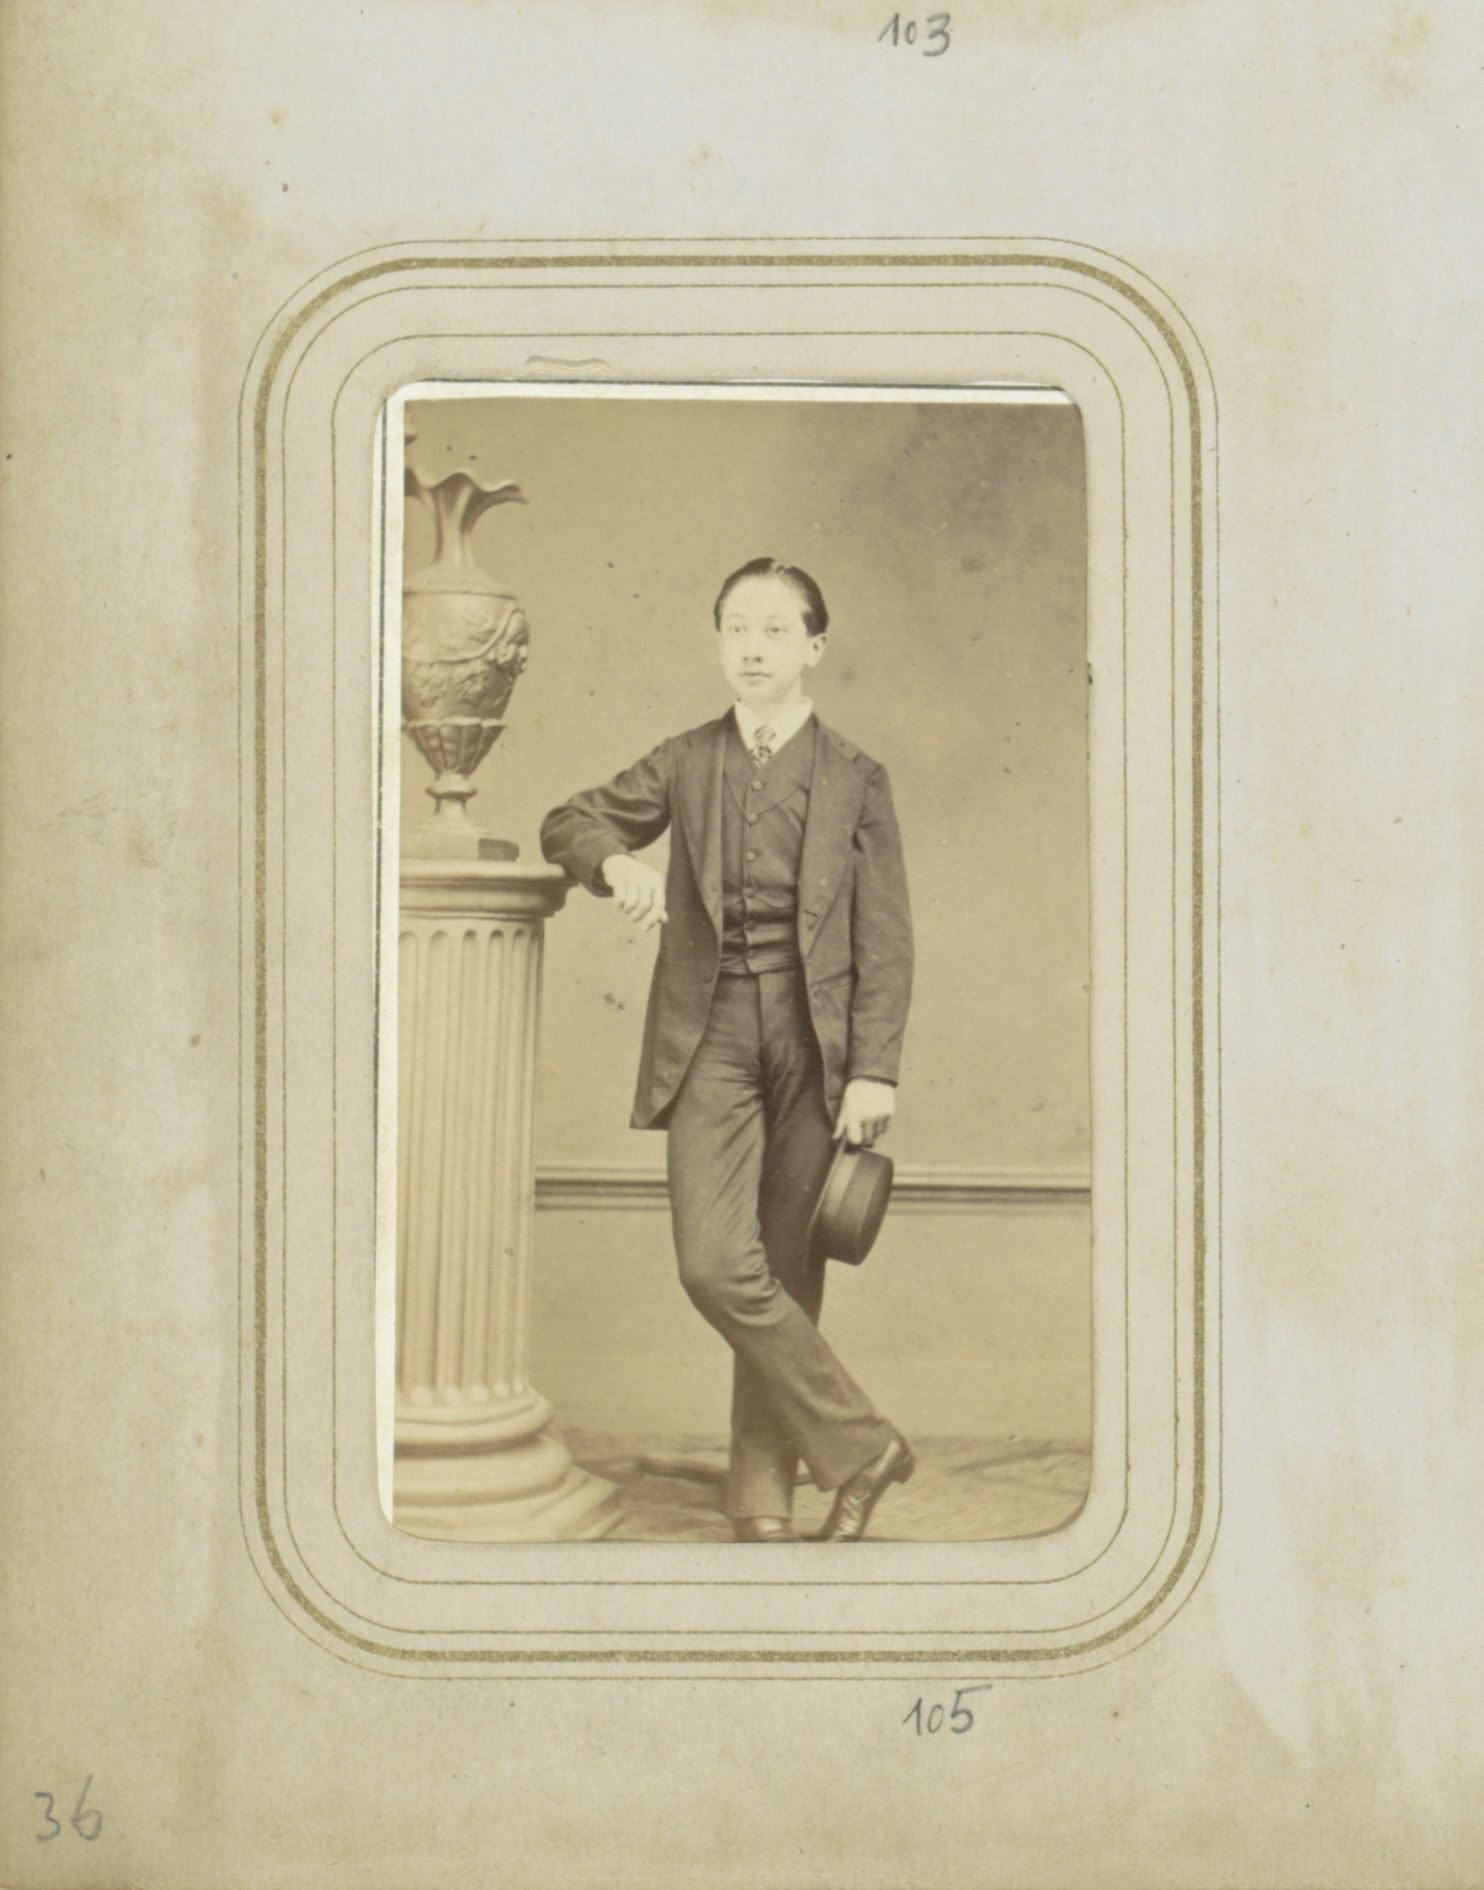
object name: carte de visite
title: Portret van A.J. Bakker in een driedelig pak met een hoed in de hand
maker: carl philip wollrabe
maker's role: fotograaf, musicus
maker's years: 1812-1887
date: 1864-1887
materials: cardboard, photographic support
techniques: albumen print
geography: the hague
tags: studio requisites ~ photographer, trousers, breeches, historical persons, head-gear: hat (+ men's clothes), clothing for the upper part of the body, family, relationship, descent, shoes, sandals, hairdress, coat, cape, the hague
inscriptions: address: ‘Boekhorststraat 91 'S Hage’, inscription: ‘portret van A.J. Bakker.’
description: Onderdeel van Familiealbum van H.W.F. Ligtenberg en L.M. Swart met 149 foto's en cartes-de-visite.